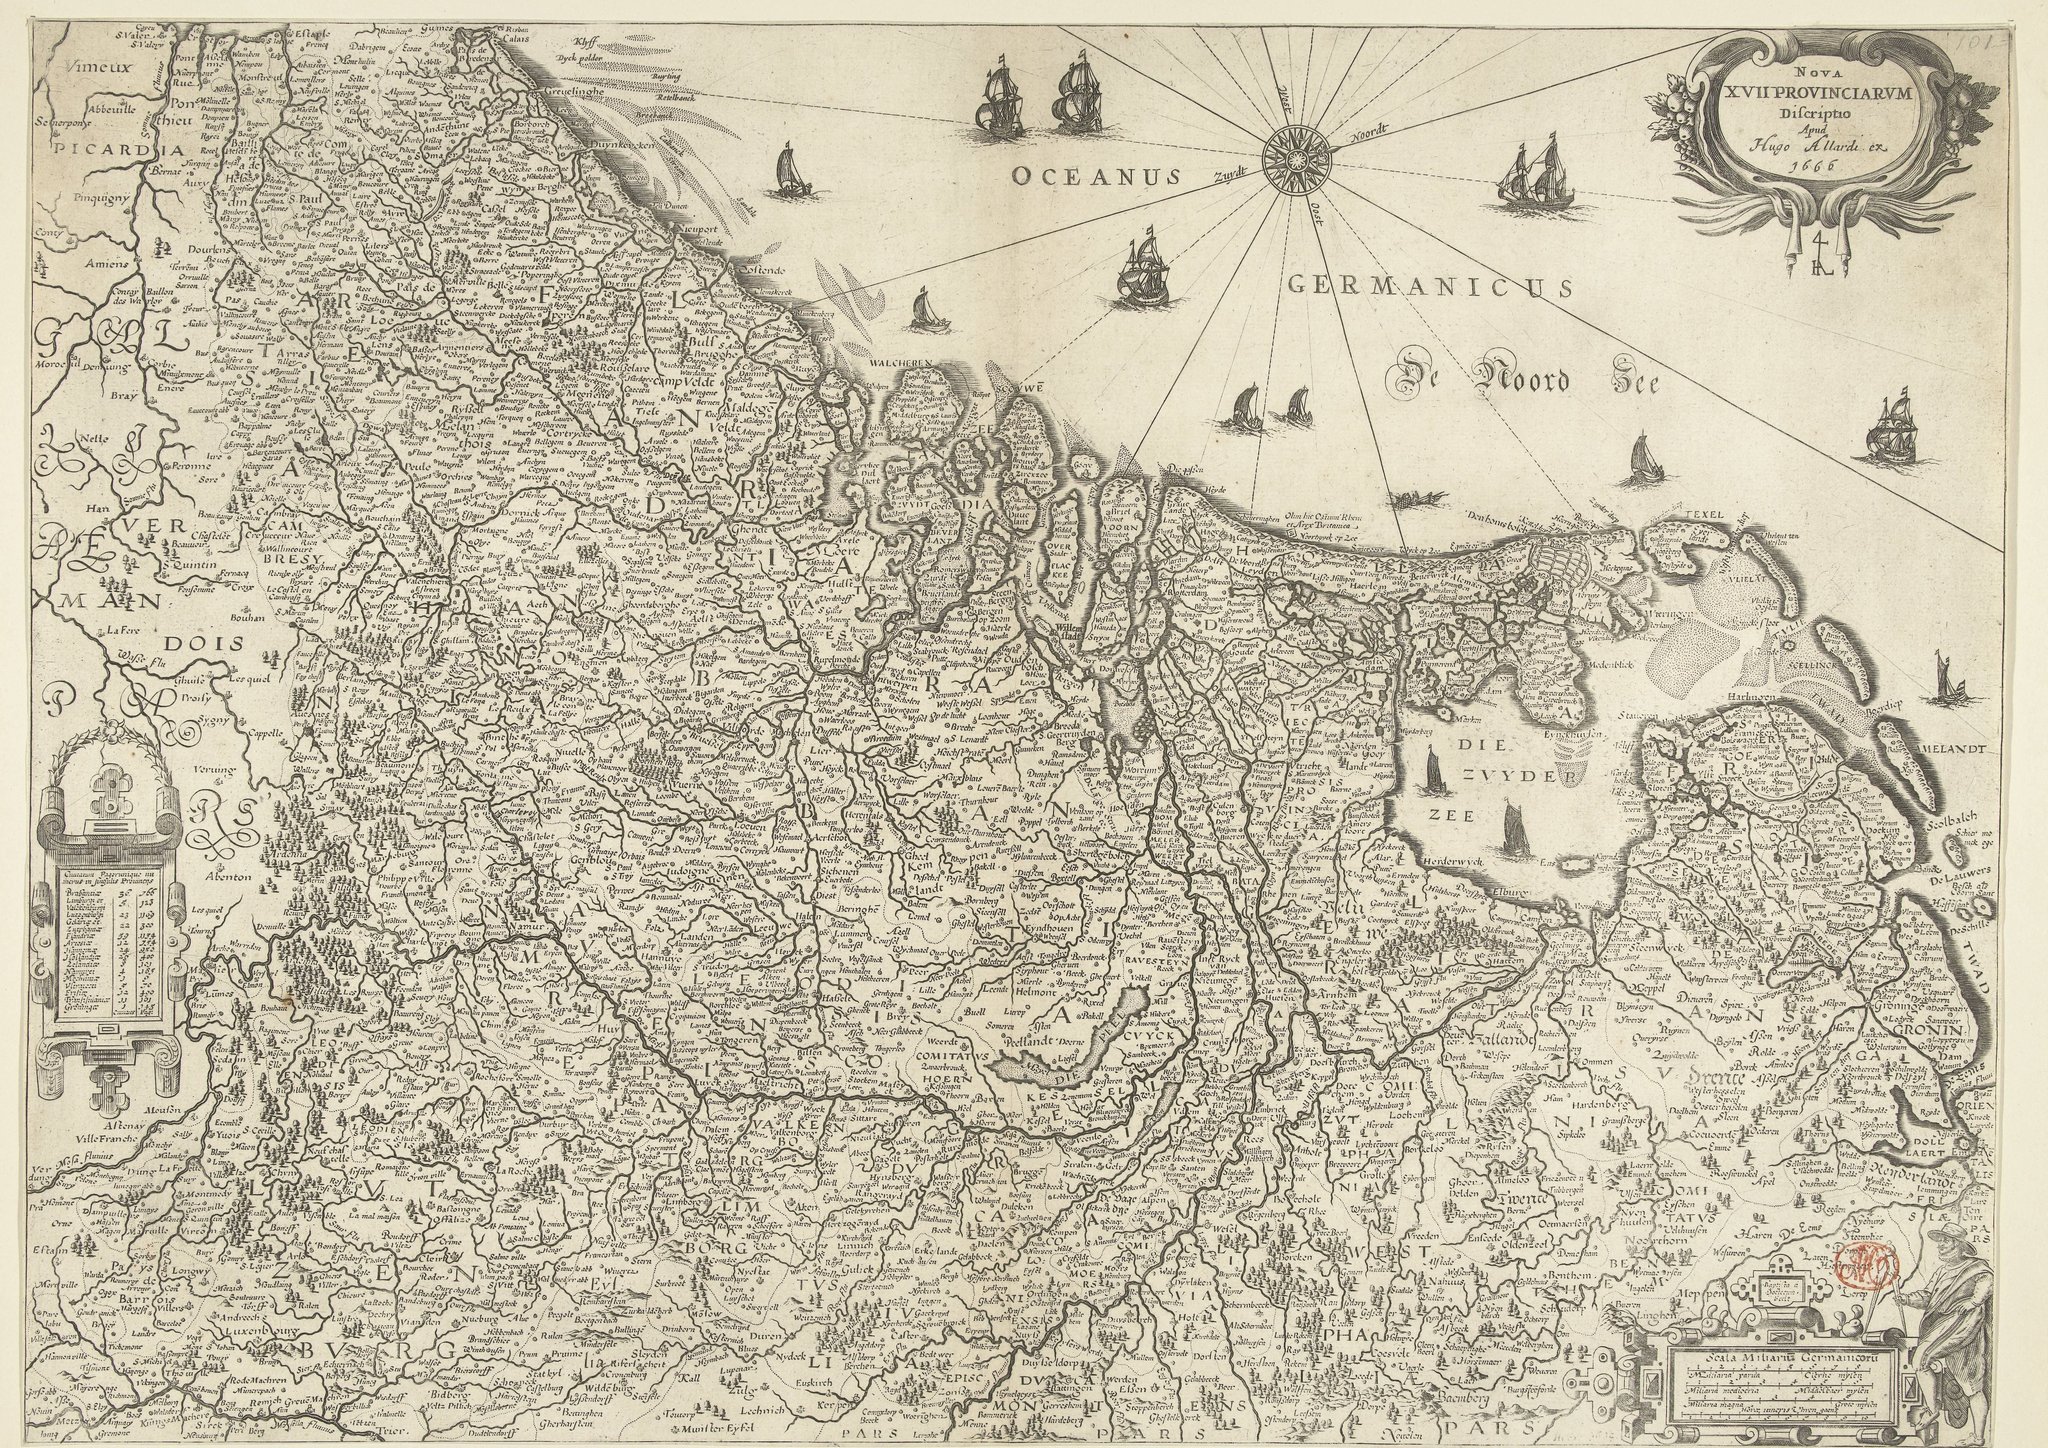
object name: map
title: Nova XVII provinciarum discriptio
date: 1666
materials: paper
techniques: engraving, etching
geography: deventer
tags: sailing-ship, sailing-boat, maps of separate countries or regions, low countries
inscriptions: collector's mark: Lugt 195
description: Kaart van de Nederlanden. Rechtsboven de titelcartouche. Links een tabel met het aantal steden en dorpen per provincie, rechtsonder een staande man met passer bij een cartouche met vier schaalstokken.